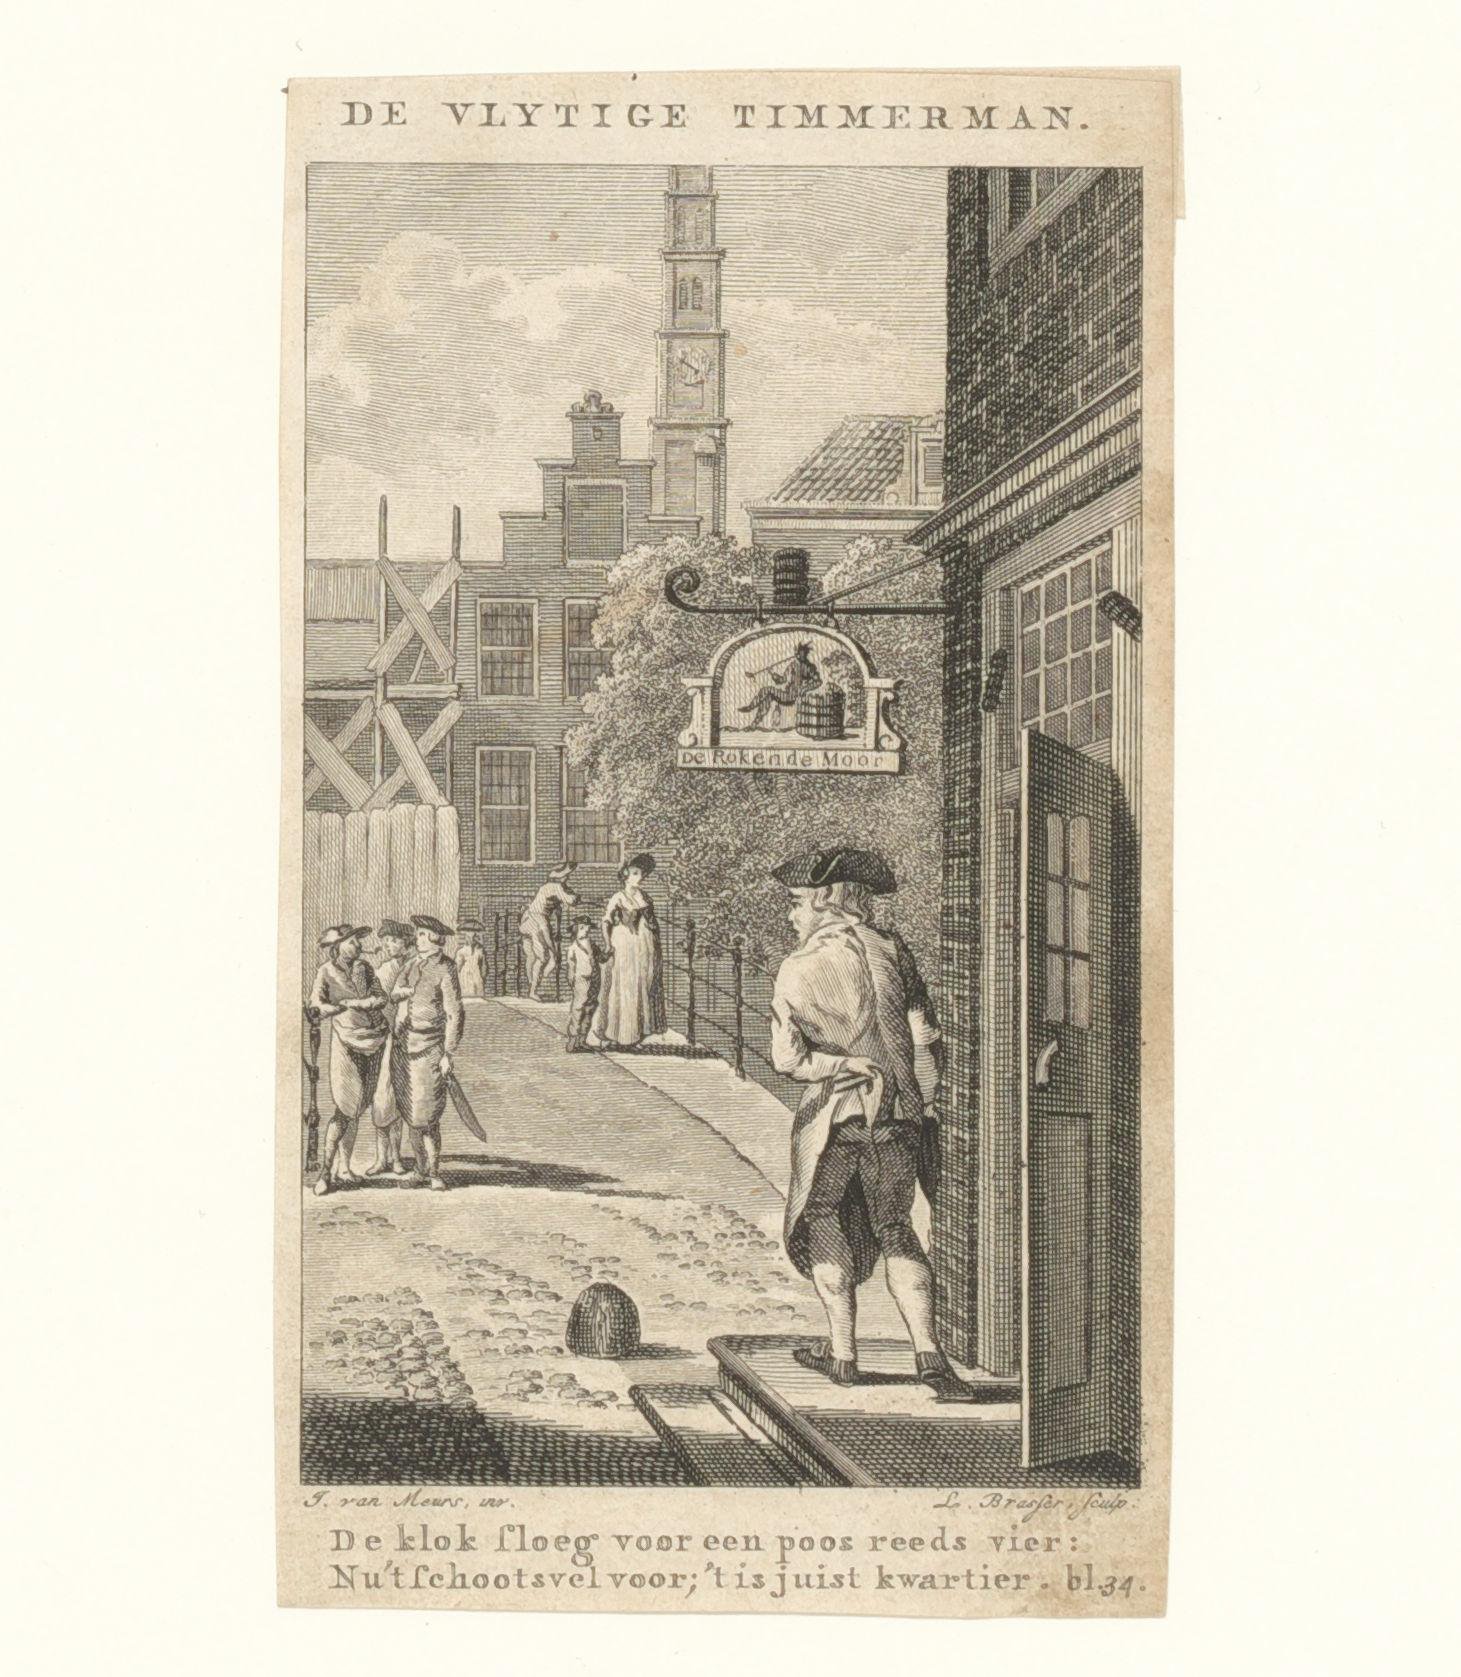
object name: print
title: De vlijtige timmerman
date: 1789-1791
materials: paper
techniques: engraving, etching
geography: netherlands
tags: carpenter, labourers going to work, pub sign, inn sign, inn, coffee-house, public house, etc.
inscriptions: collector's mark, collector's mark: Lugt 1641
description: Gebruikt als illustratie in: Volks-liedjes, uitgegeven door de Maatschappij tot Nut van 't Algemeen, Amsterdam: Harmanus Keijzer, Arend Fokke en Cornelis de Vries, 3 delen, 1789-1791, p. 38/39.